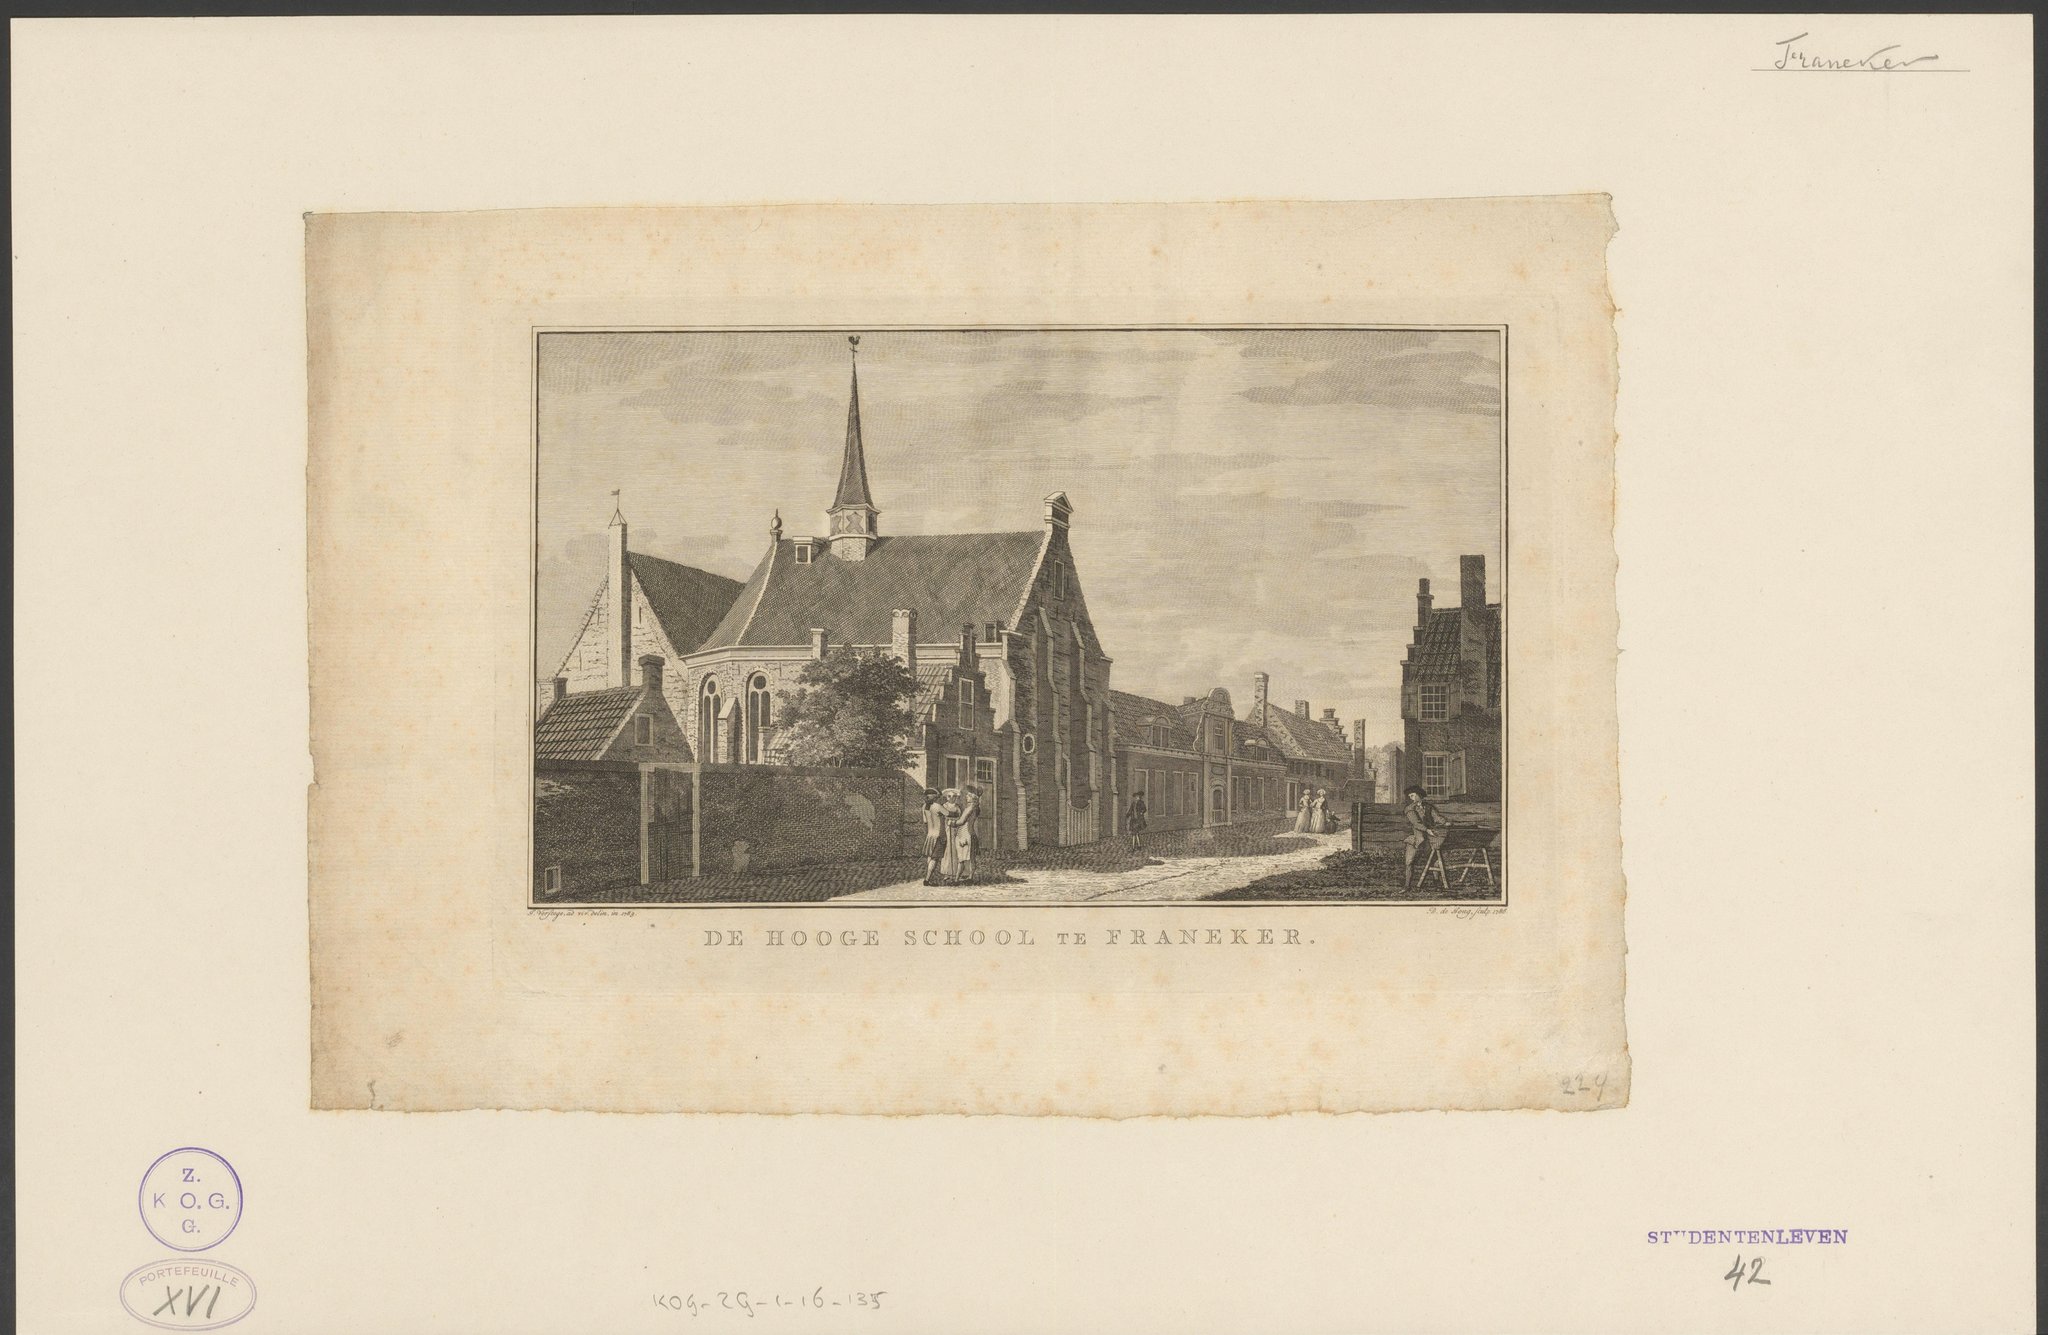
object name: print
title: Gezicht op de universiteit te Franeker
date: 1786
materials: paper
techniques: etching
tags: university building, college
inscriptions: collector's mark: Lugt 1641, stamp, stamp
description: Gezicht op de universiteit te Franeker (gevestigd in het voormalige Kruisherenklooster te Franeker). Op straat diverse figuren. Onderwerpsrubrieken binnen de Atlas Zeden en Gewoonten: Onderwijs en Wetenschappen, Studentenleven.